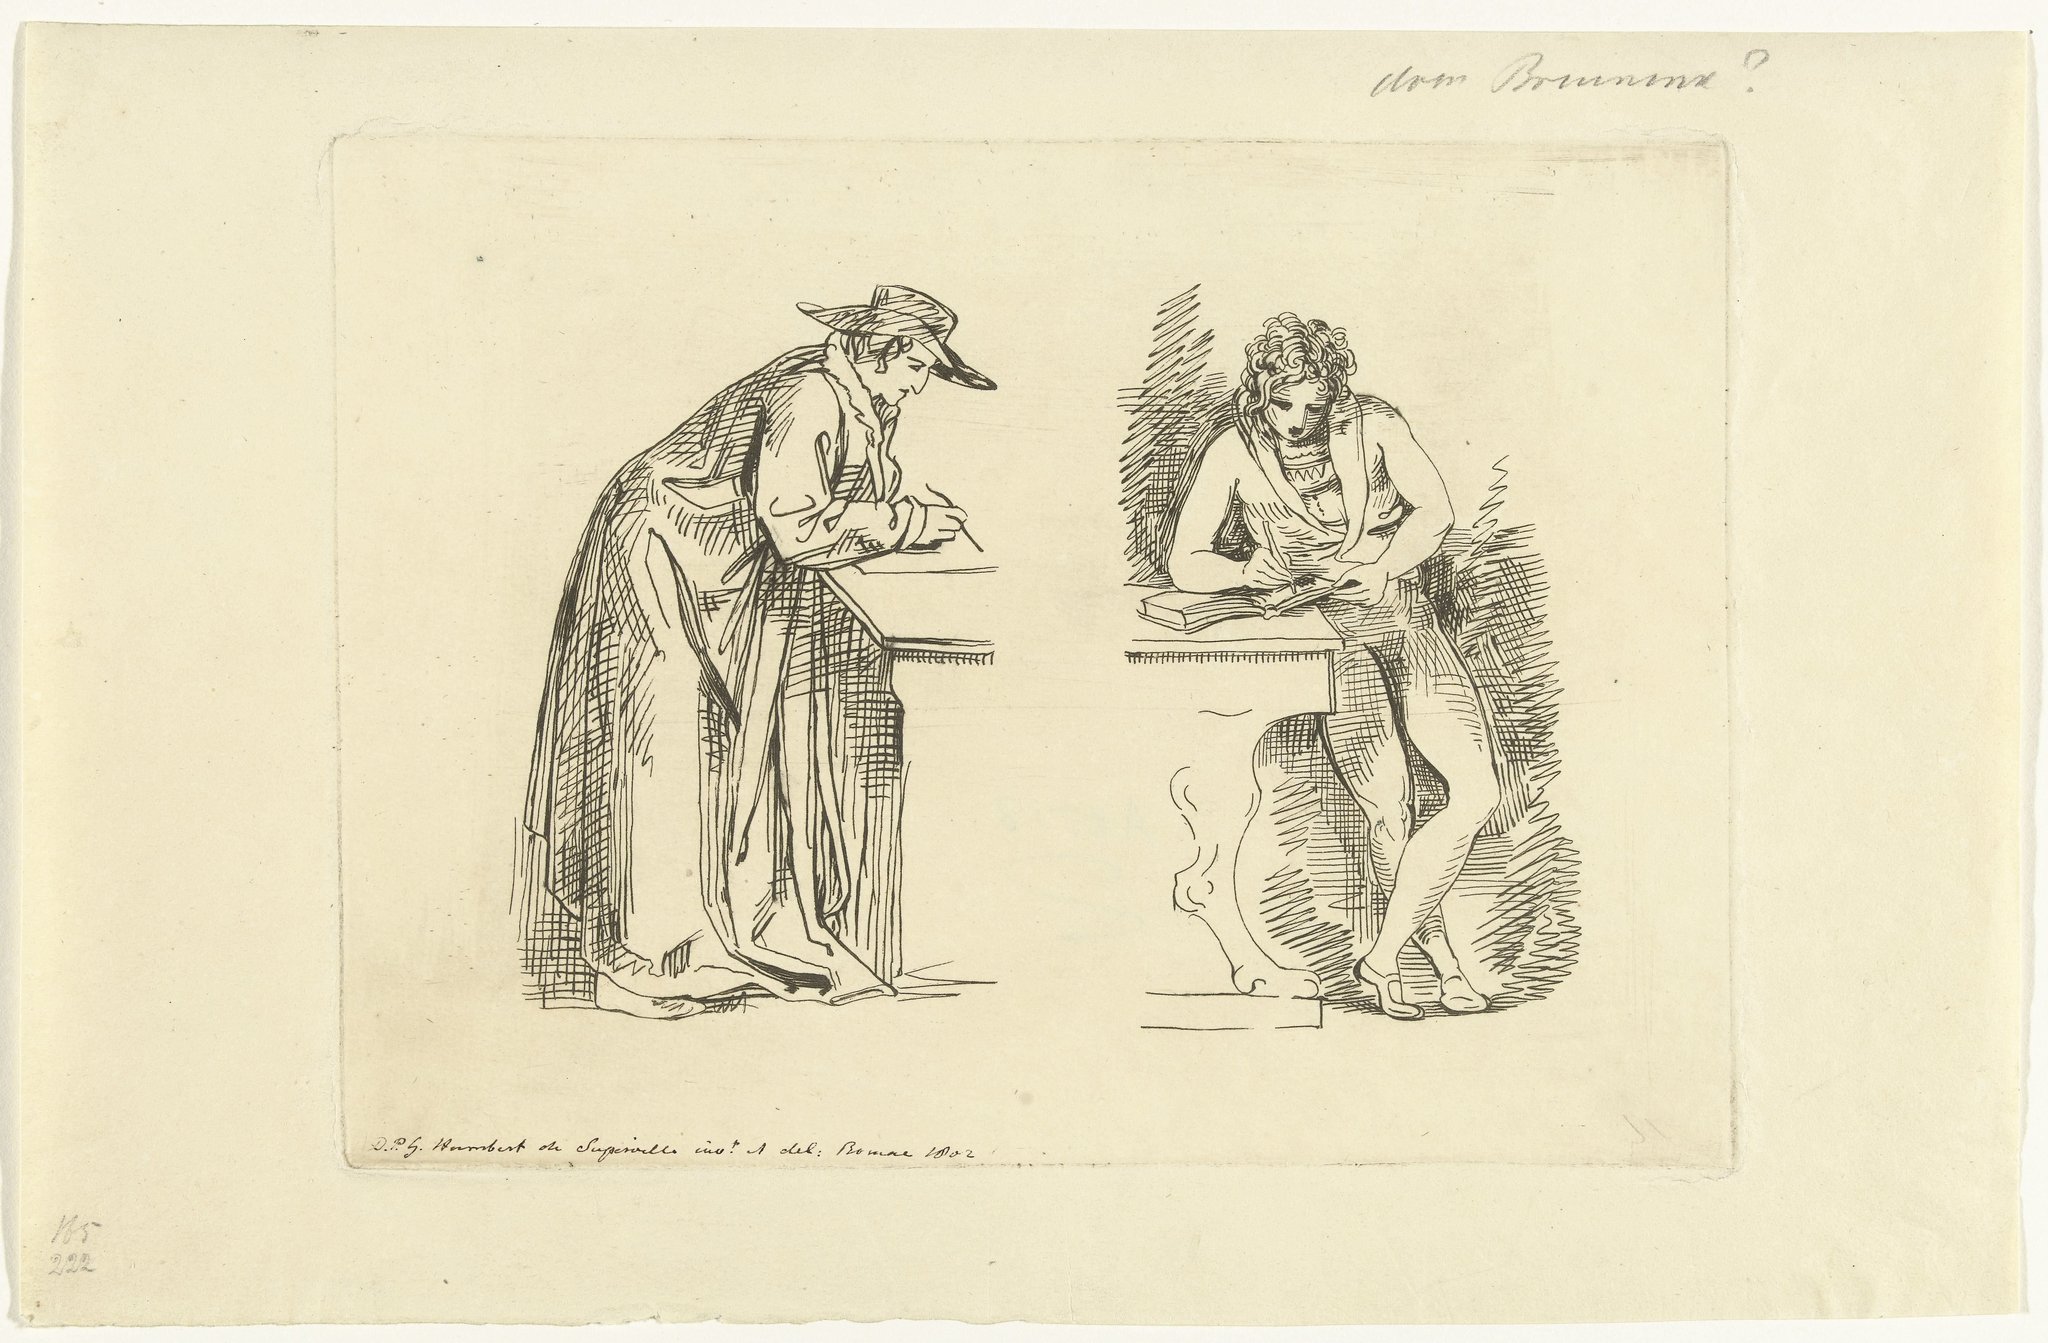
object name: print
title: Studieblad met twee mannenfiguren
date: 1802-1850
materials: paper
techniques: etching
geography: rome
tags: author, poet writing, lectern ~ reading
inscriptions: inscription: ‘D.P.G. Hubert de Superville invt. et del.: Romae 1802’, collector's mark: Lugt 2228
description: Twee mannenfiguren staand aan schrijflessenaars. De linke figuur draagt een opvallende hoed en een lange jas, de rechte leunt nonchalant tegen de lessenaar en schrijft in een boek.